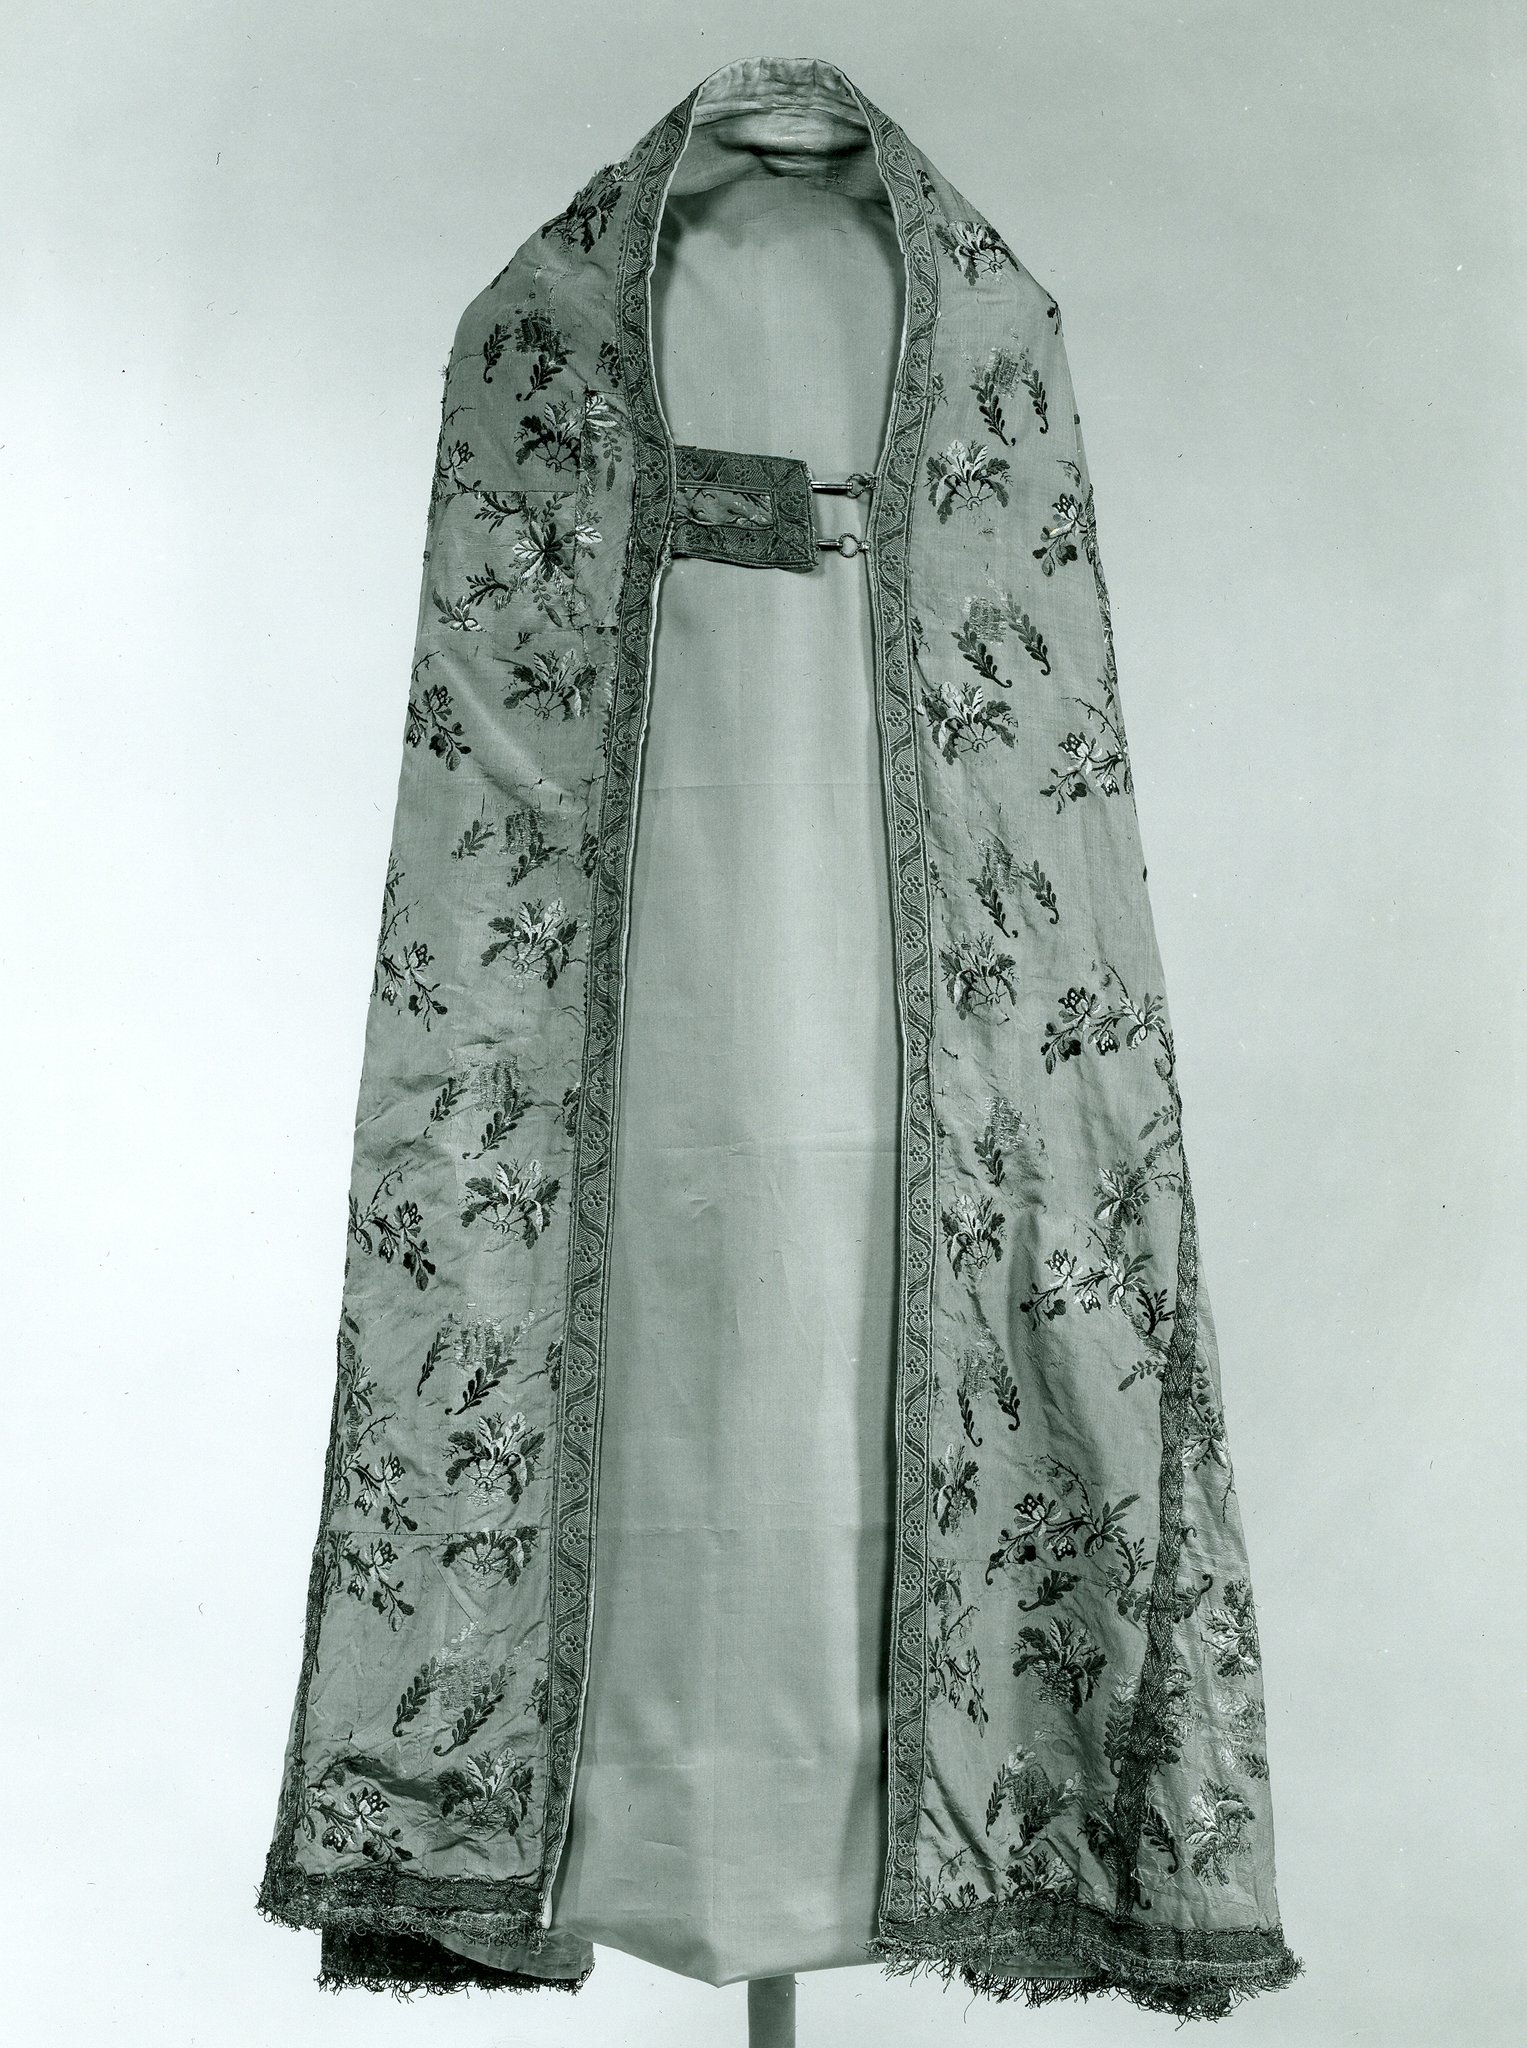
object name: cope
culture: french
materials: cotton, metal, silk